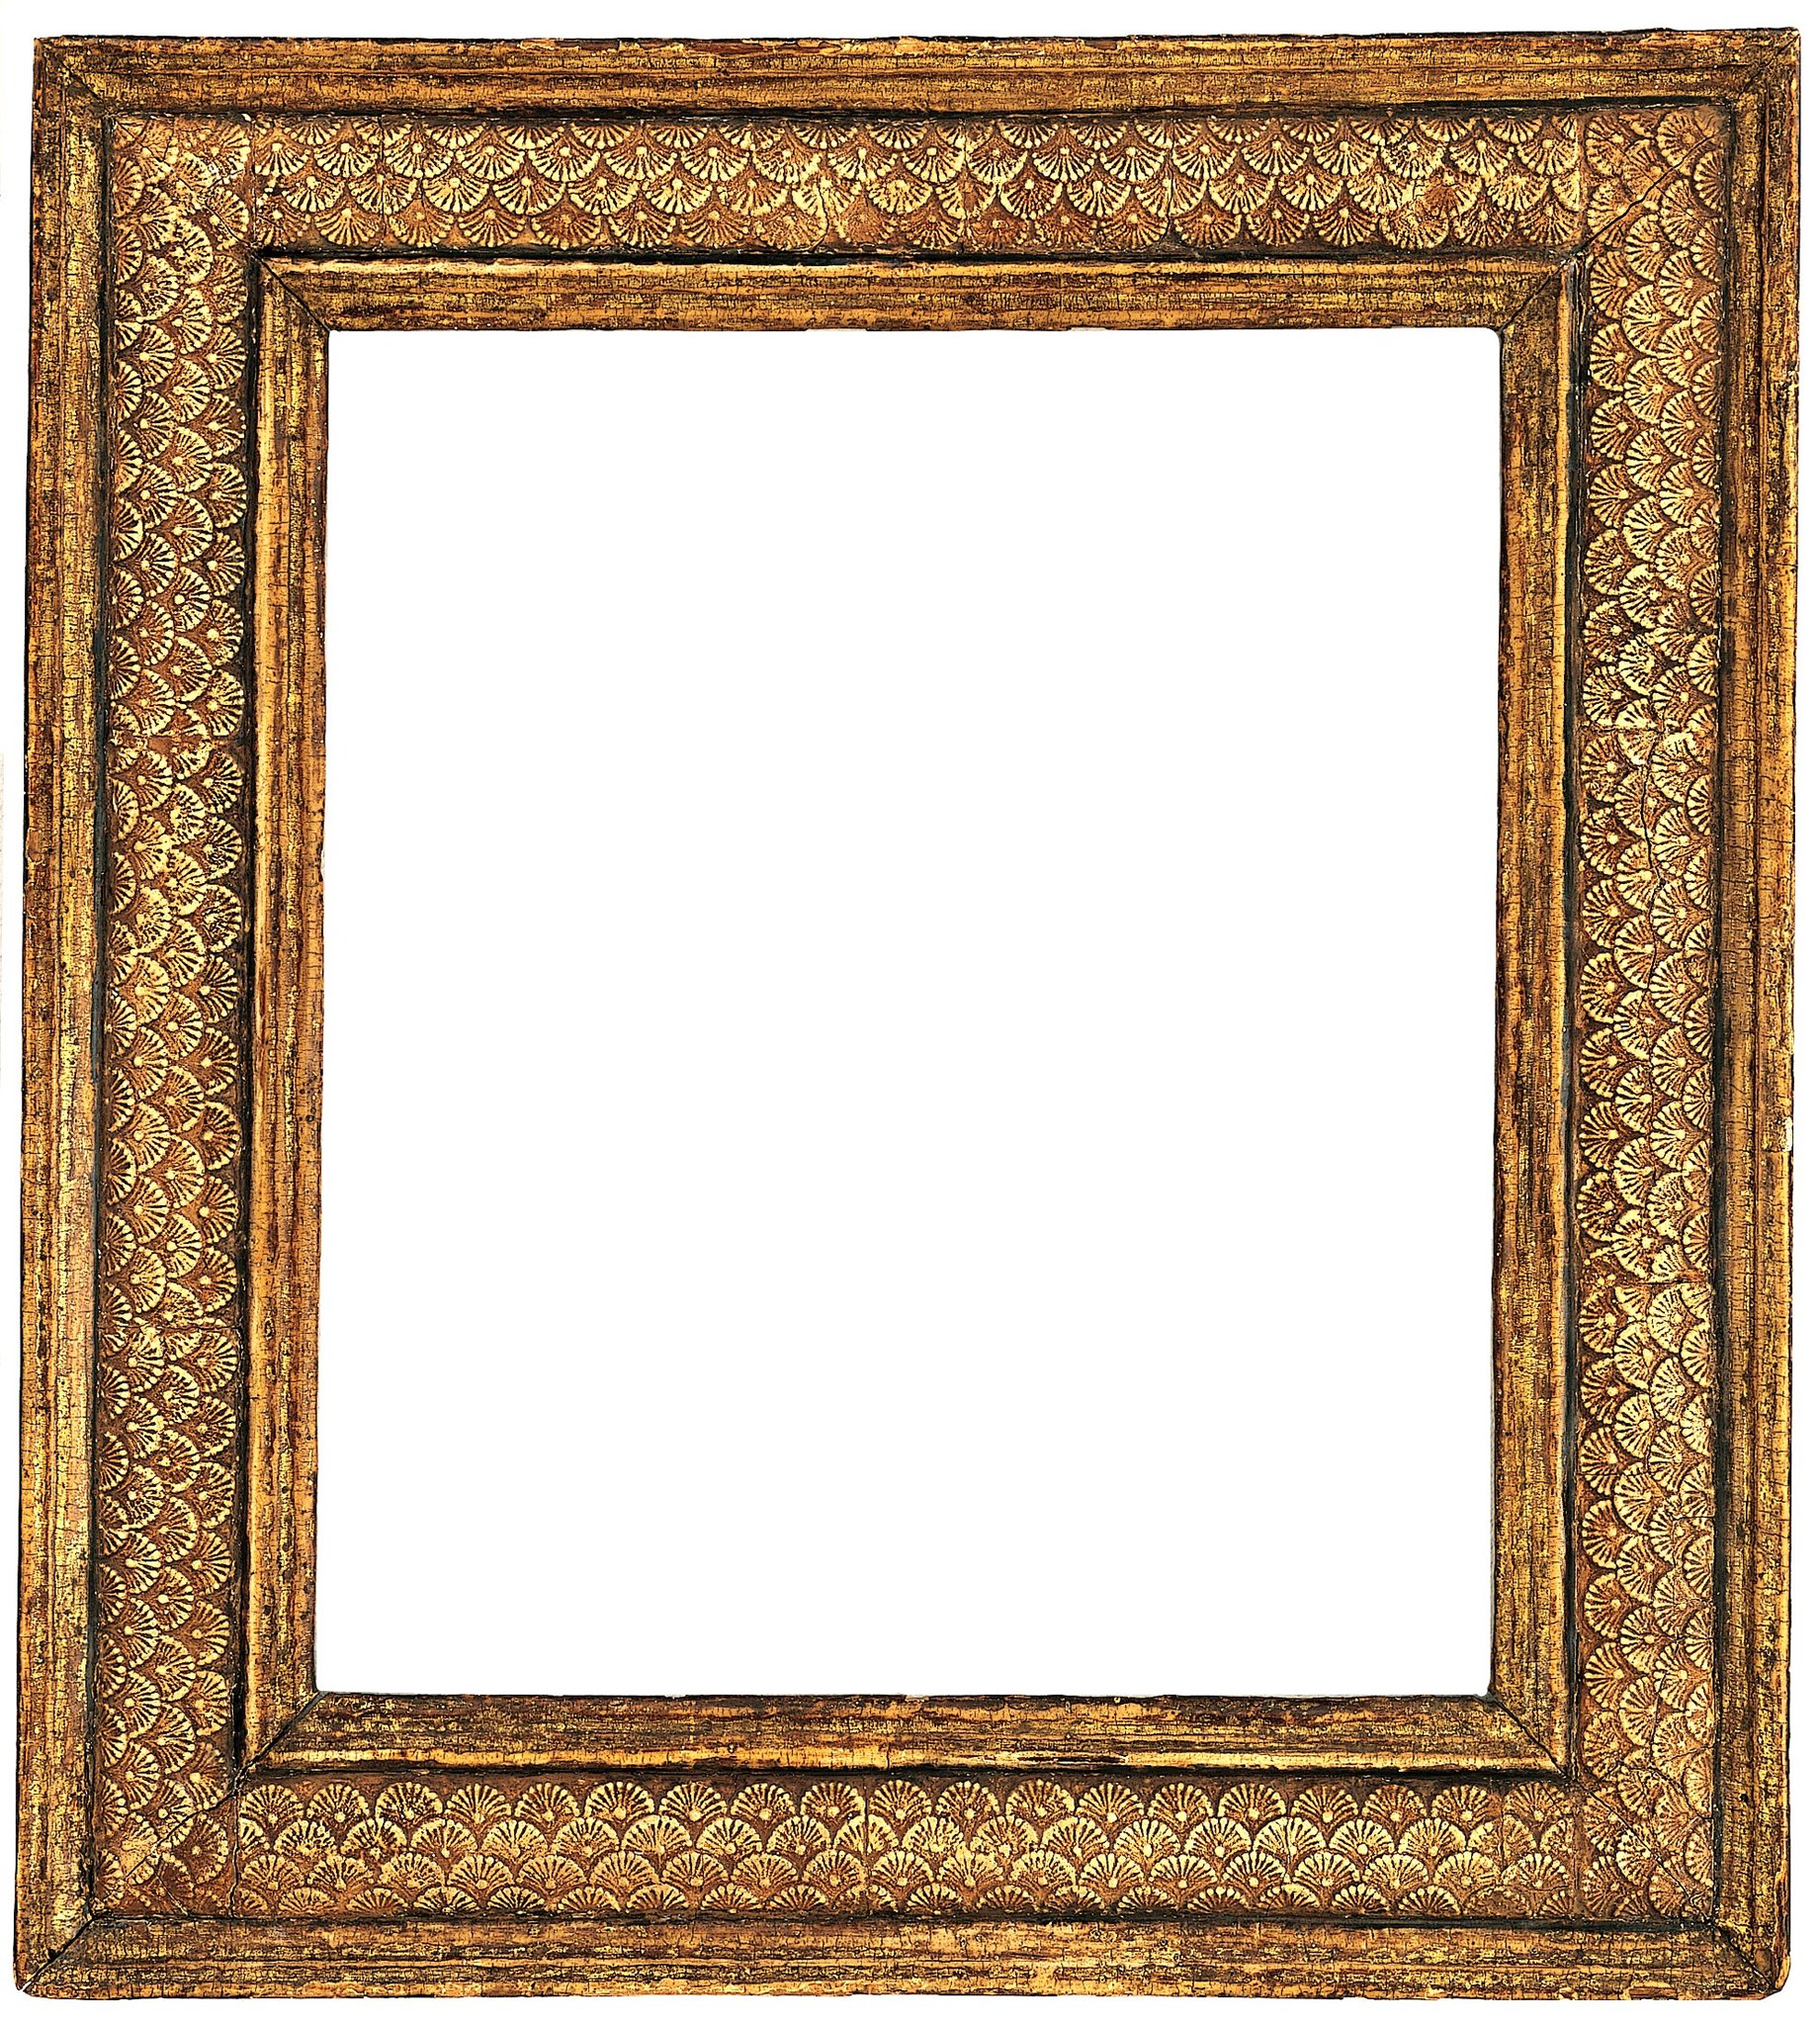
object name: frame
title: Cassetta Frame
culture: italian, veneto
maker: italian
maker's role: artist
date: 1534-1566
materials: wood